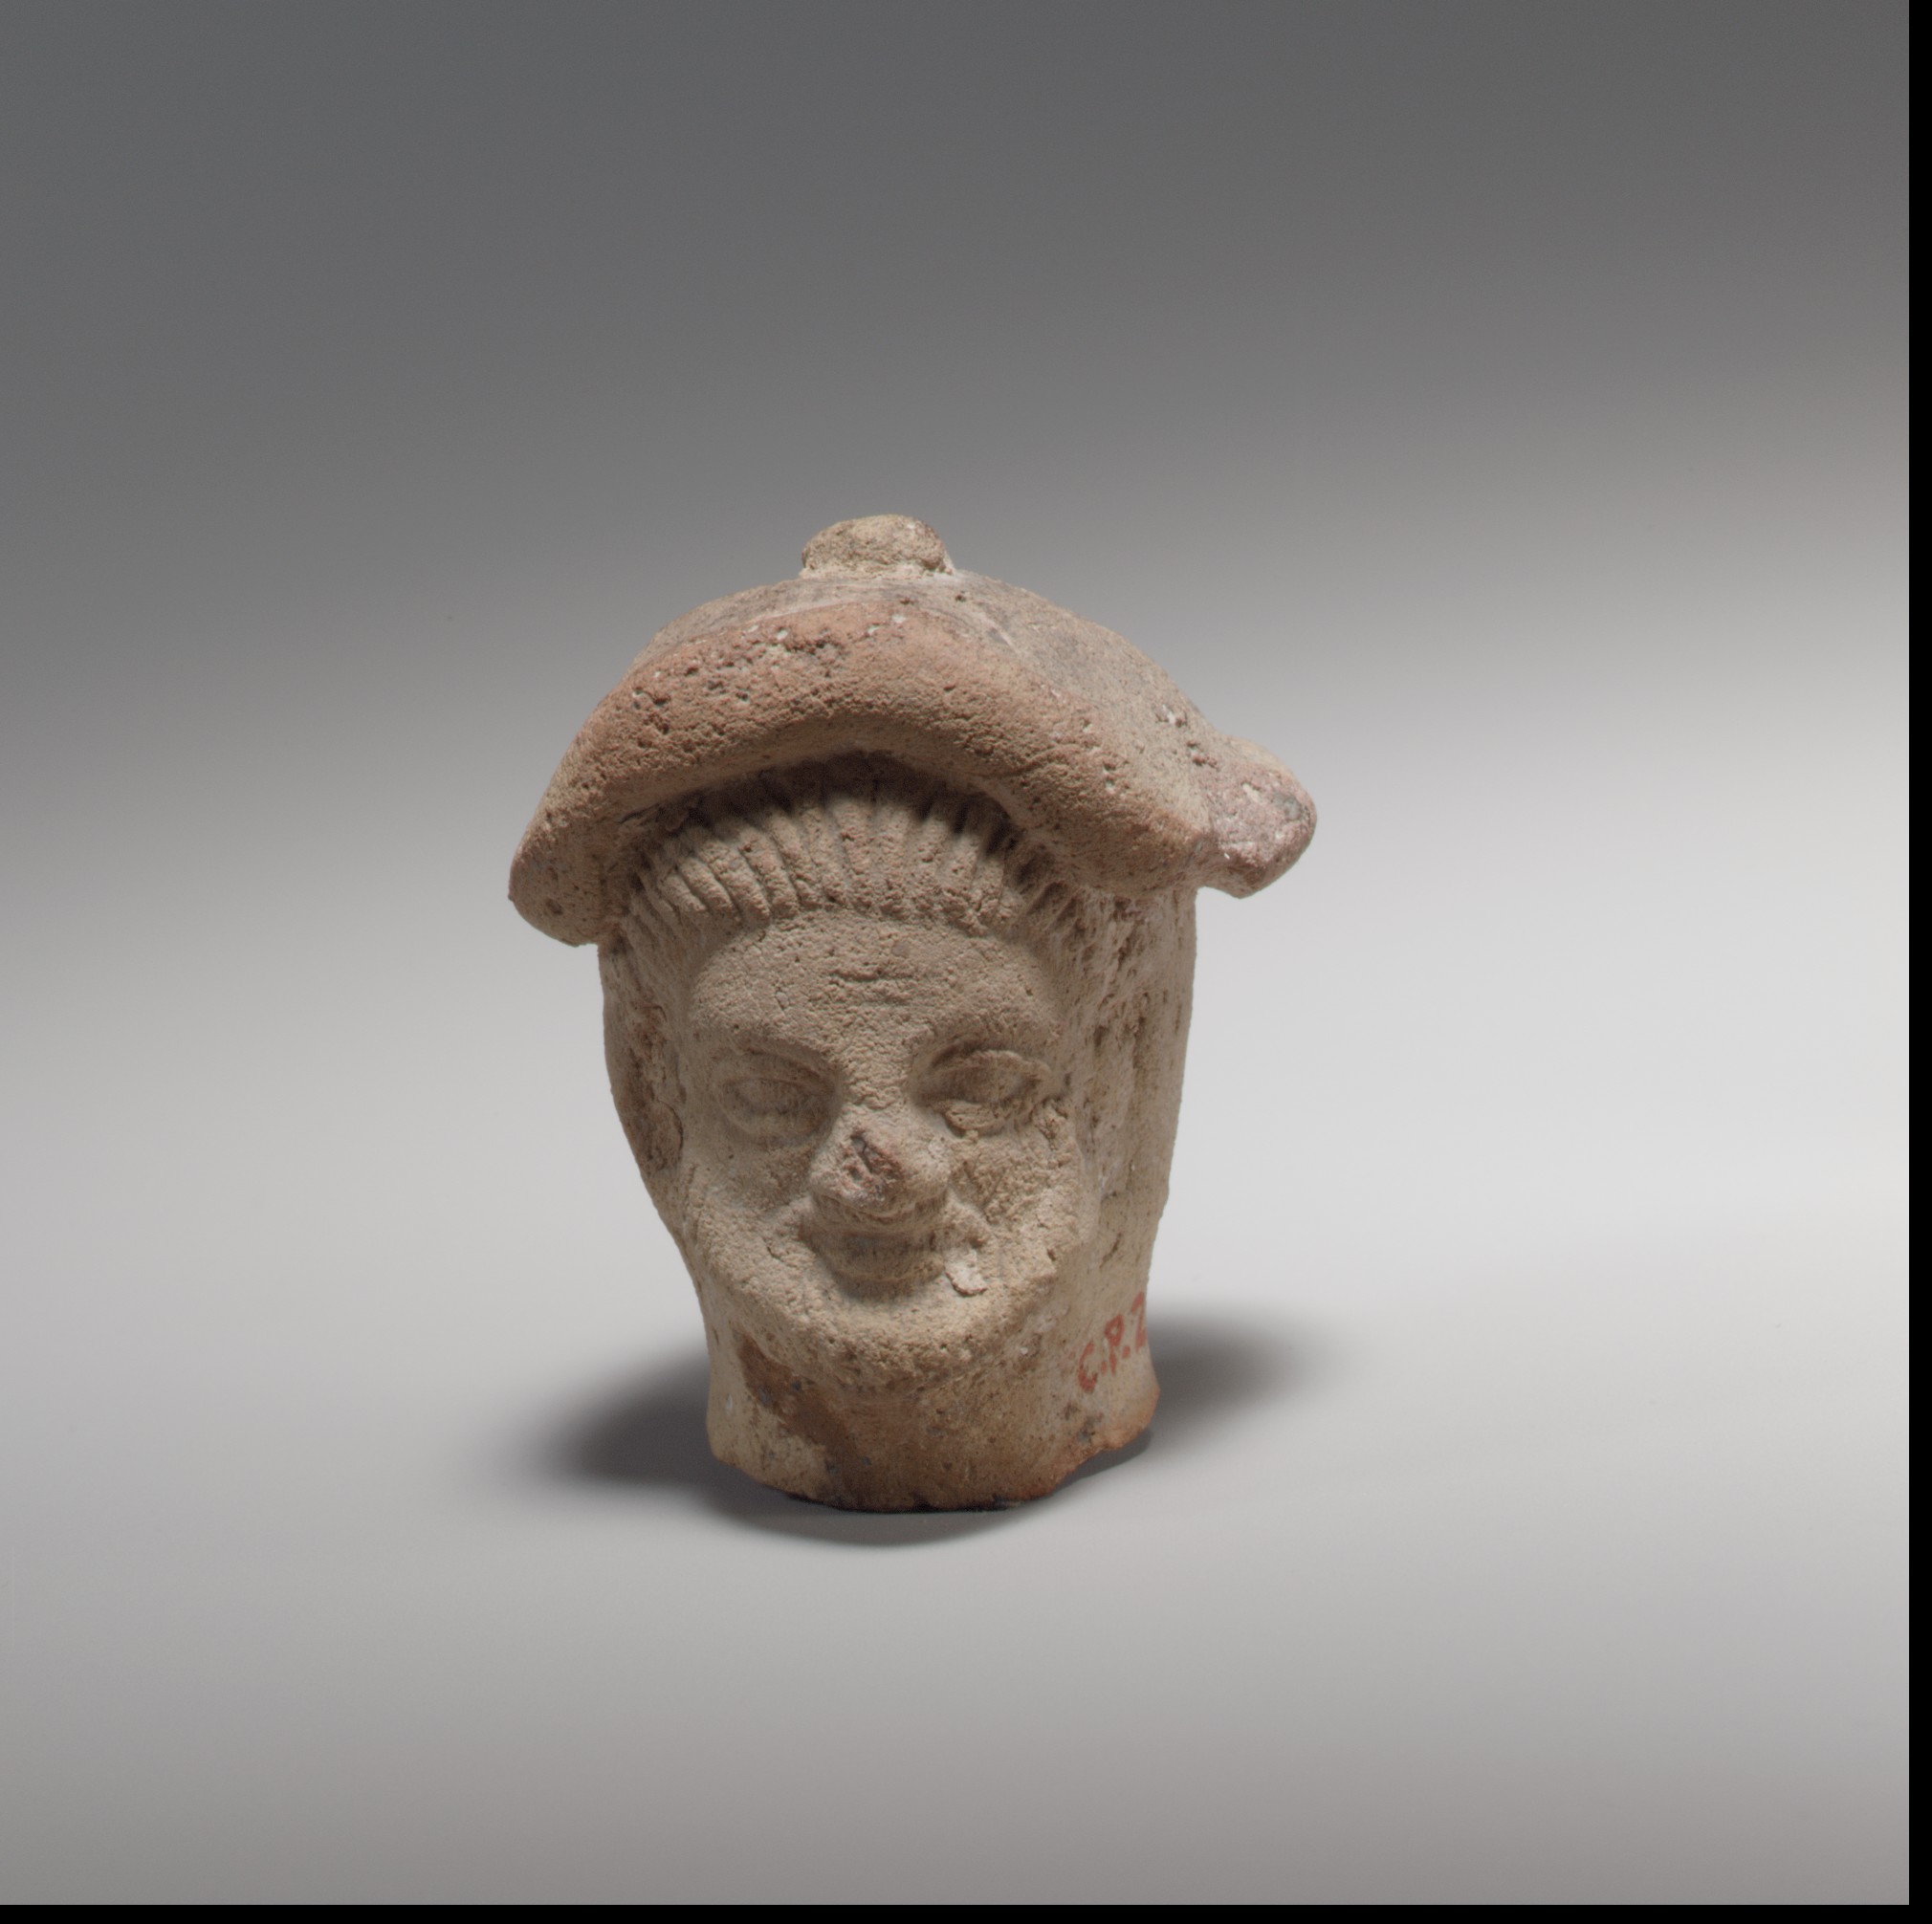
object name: head of a male votary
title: Male head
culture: cypriot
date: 500-301 BCE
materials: terracotta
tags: heads,men